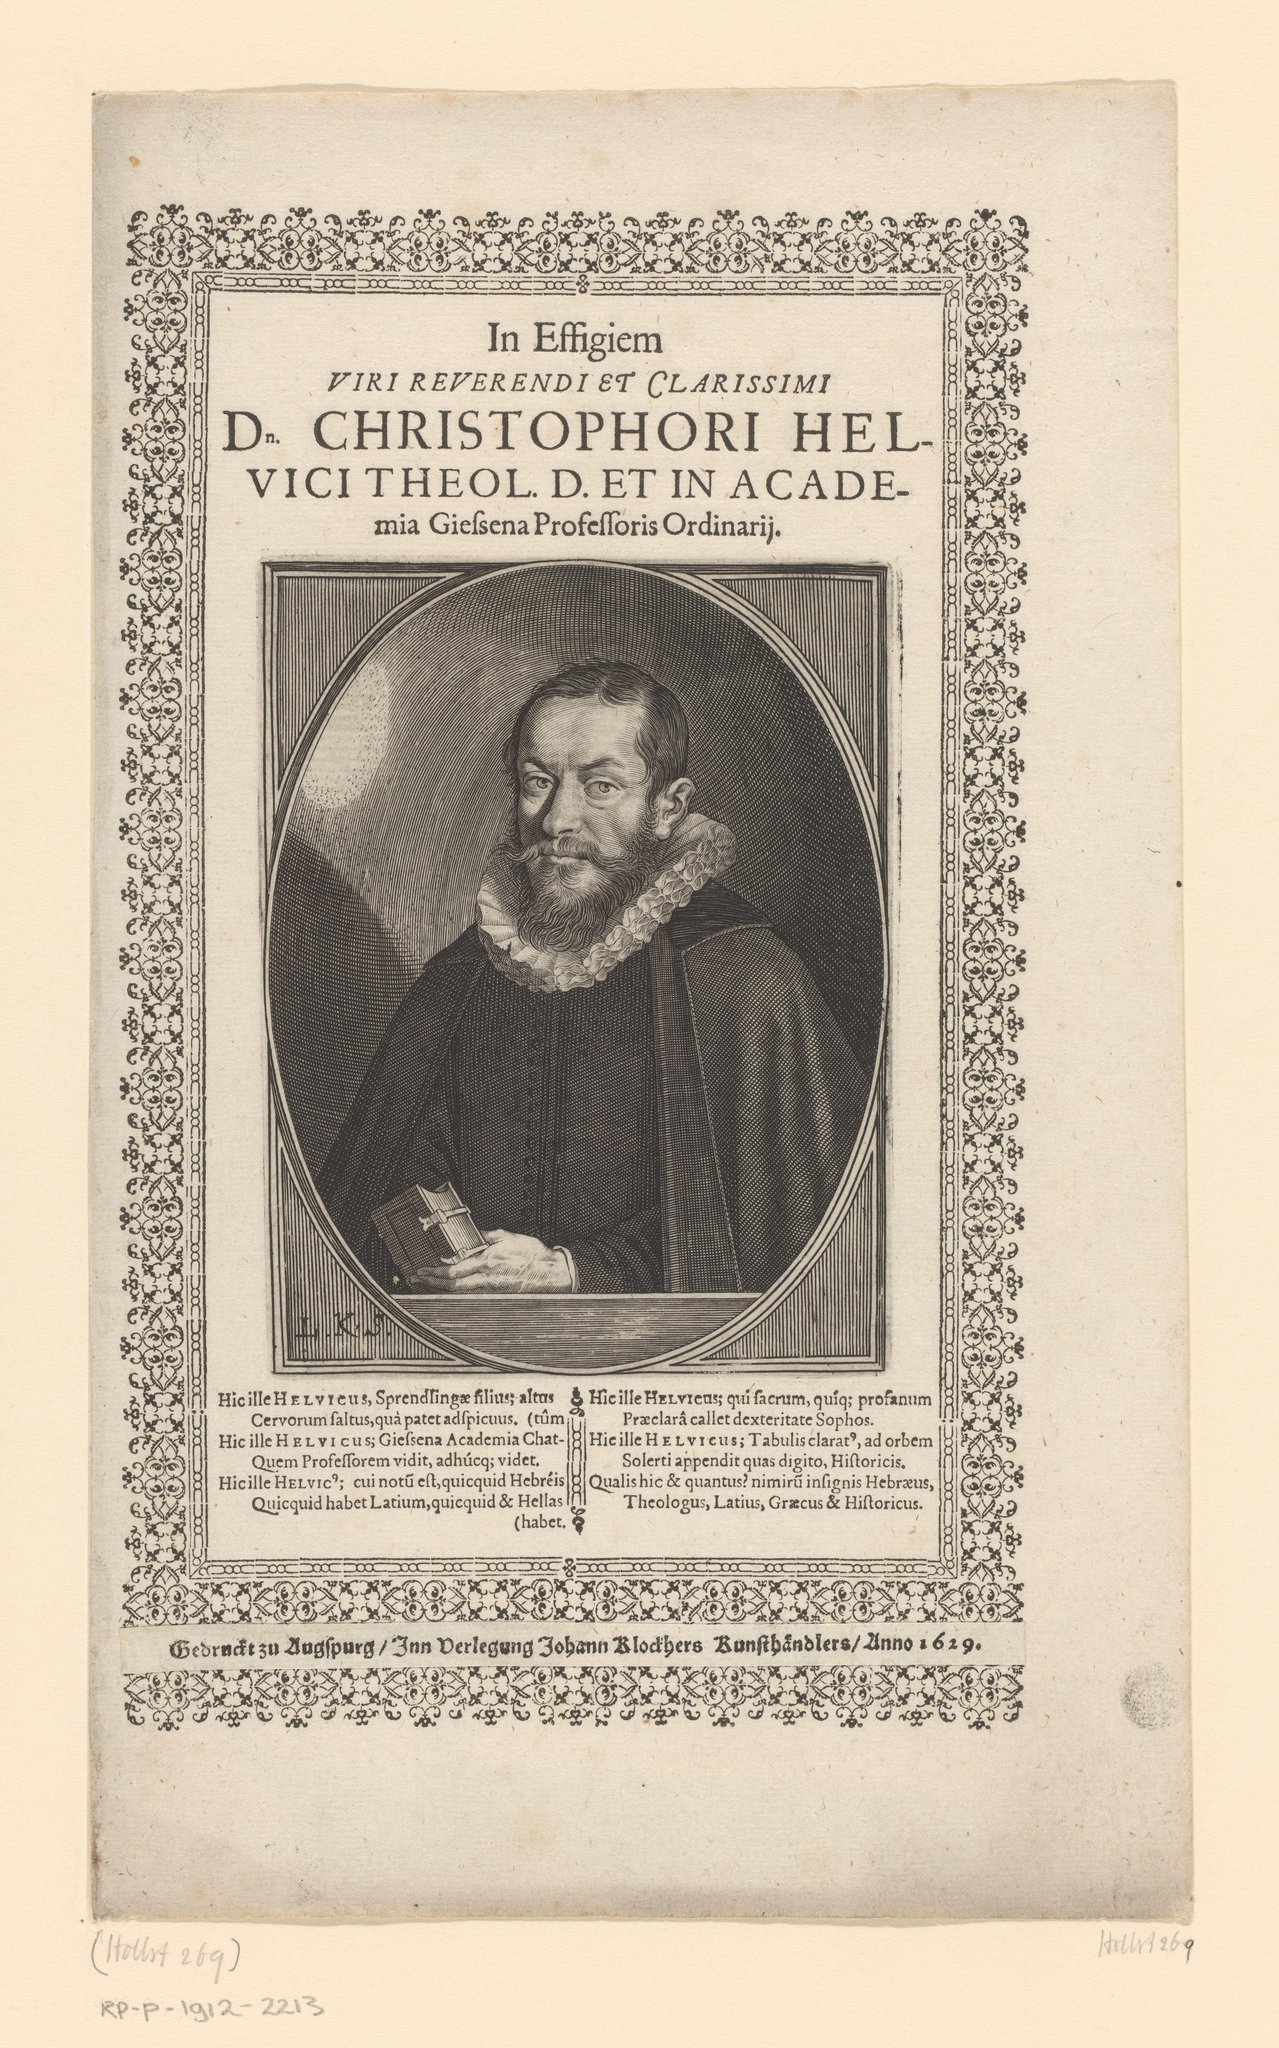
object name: print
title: Portret van Christoph Helwig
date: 1629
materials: paper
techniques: engraving, letterpress printing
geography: augsburg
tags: theologian, historical persons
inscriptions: collector's mark: Lugt 2228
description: Tekst in het Latijn in boekdruk op het blad binnen een omkadering van fleurons.